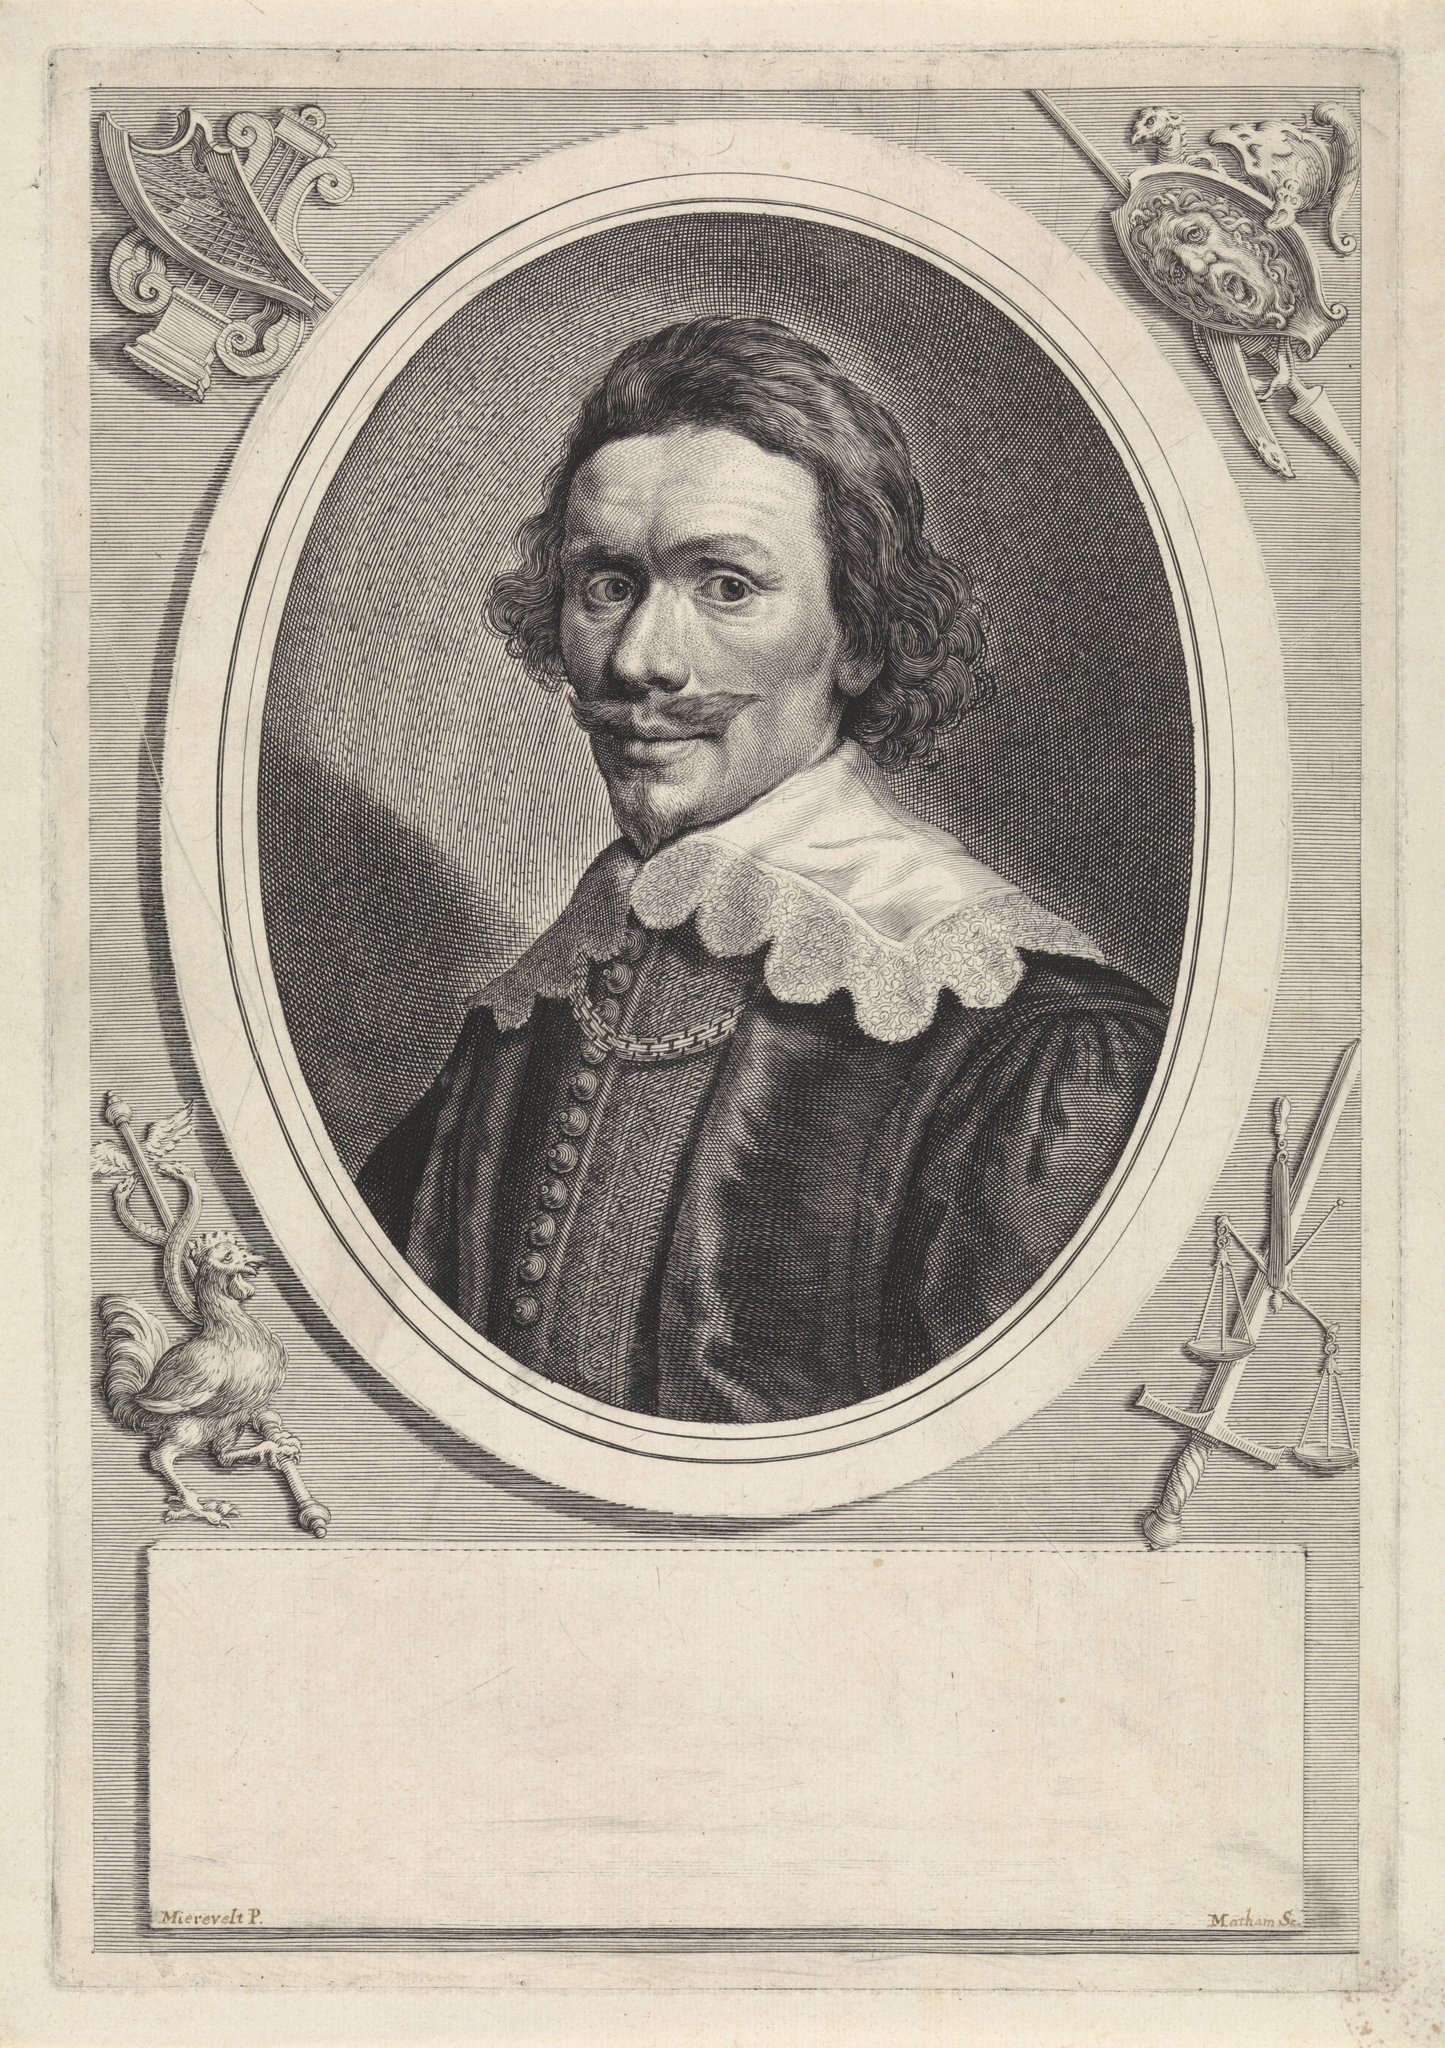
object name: print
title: Portret van Theodorus Johannes Dirk Graswinckel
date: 1636-1666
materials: paper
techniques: engraving, pen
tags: theodorus johannes dirk graswinckel, symbols of the lawsuit, lyre, cithara, psaltery, scales, attributes of minerva, caduceus (staff with two snakes, attribute of mercury)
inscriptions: collector's mark: Lugt 240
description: Portret van Theodorus Johannes Dirk Graswinckel, advocaat-fiscaal van Holland, jurist en humanist. Tevens van hij dichter en bevriend met P.C. Hooft. Rond het portret symbolen van een goede rechtspraak (caduceus van Mercurius, balans en zwaard van Justitia en wapenrusting van Minerva) en van de dichtkunst (harp en lier).